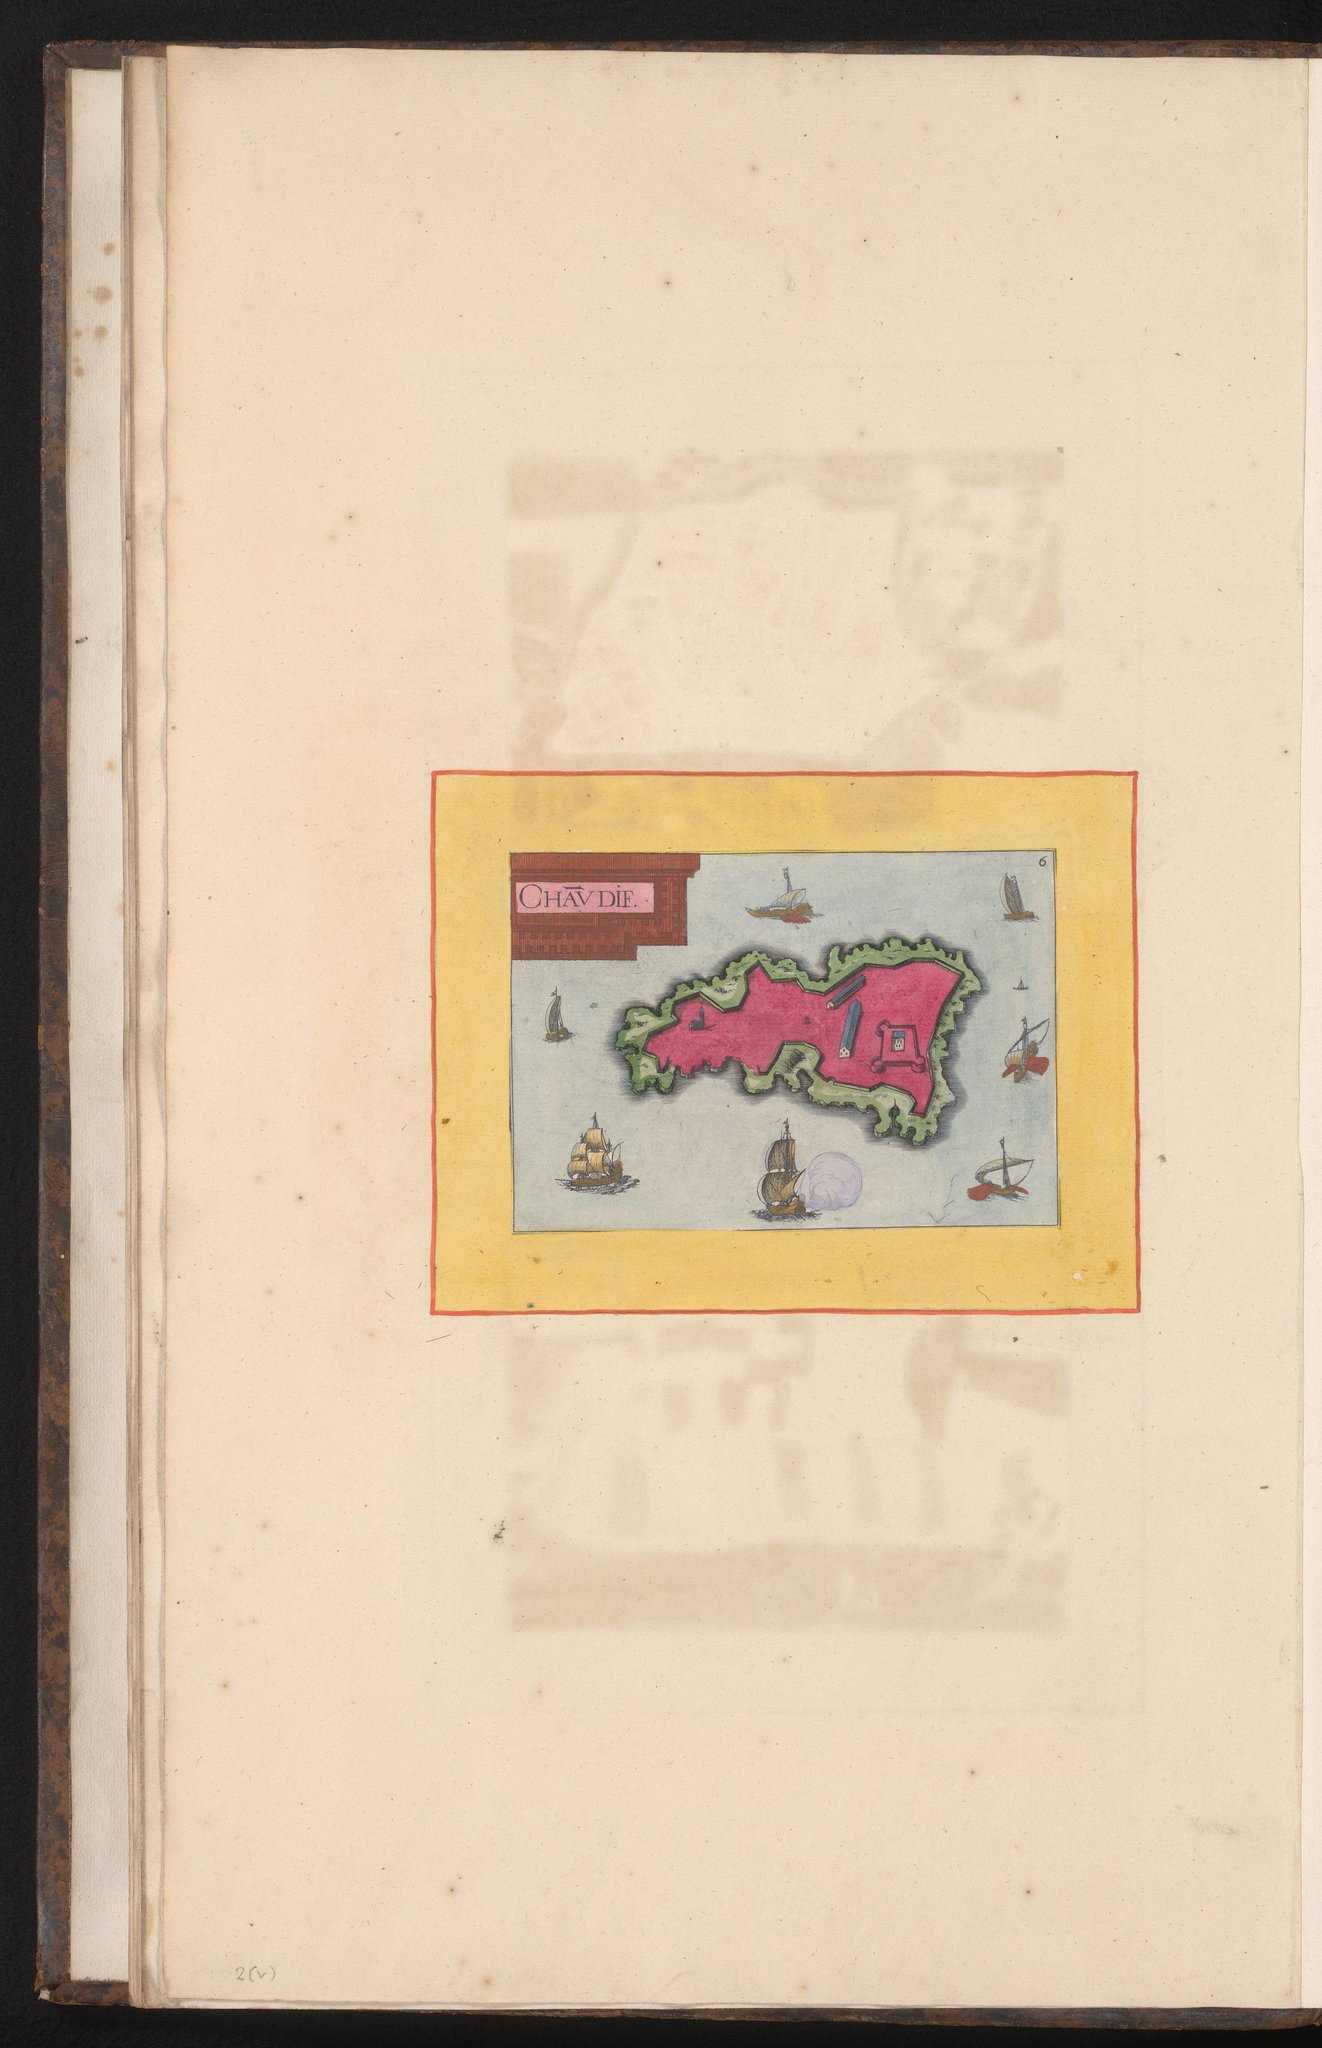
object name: album leaf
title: Chau Dif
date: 1638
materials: paper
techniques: engraving, etching, hand coloring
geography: the hague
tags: maps of cities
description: Prent uit: Tassin, Christophe. Les plans et profils de toutes les principales villes et lieux considérables de France (...). Parijs: Michel van Lochom, 1638, prent nummer 6 in het deel 'Provence'.